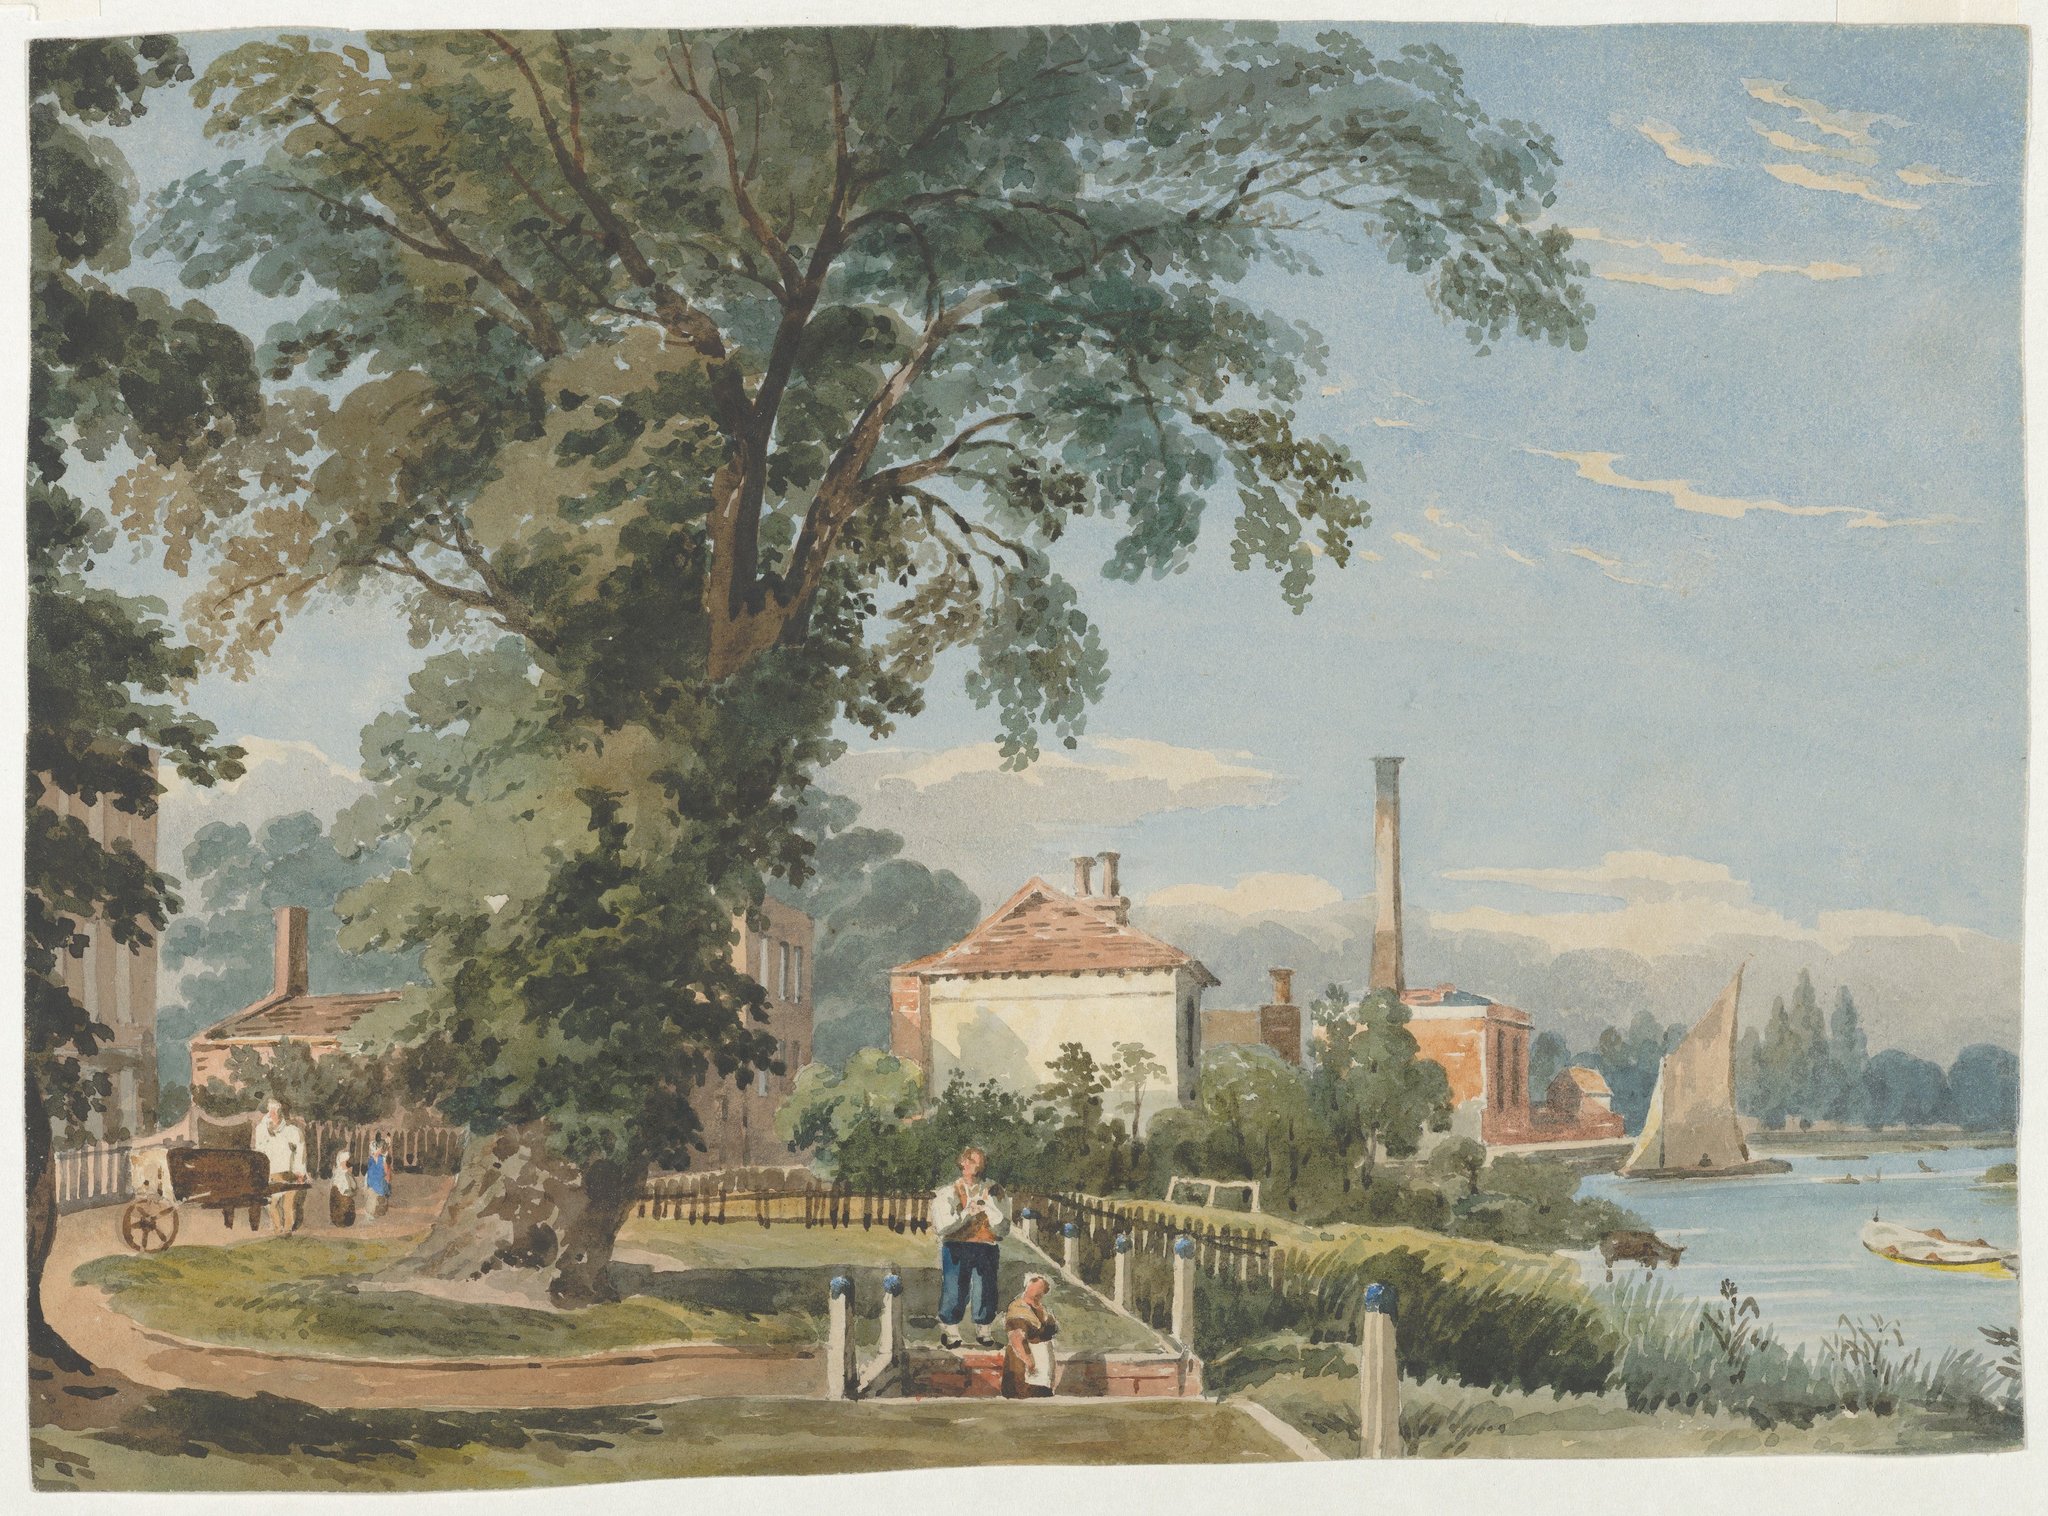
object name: drawing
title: On the Thames at Hammersmith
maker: john varley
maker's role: artist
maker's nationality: british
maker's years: 1778-1842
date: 1836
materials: graphite, watercolor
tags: buildings,rivers,trees,london